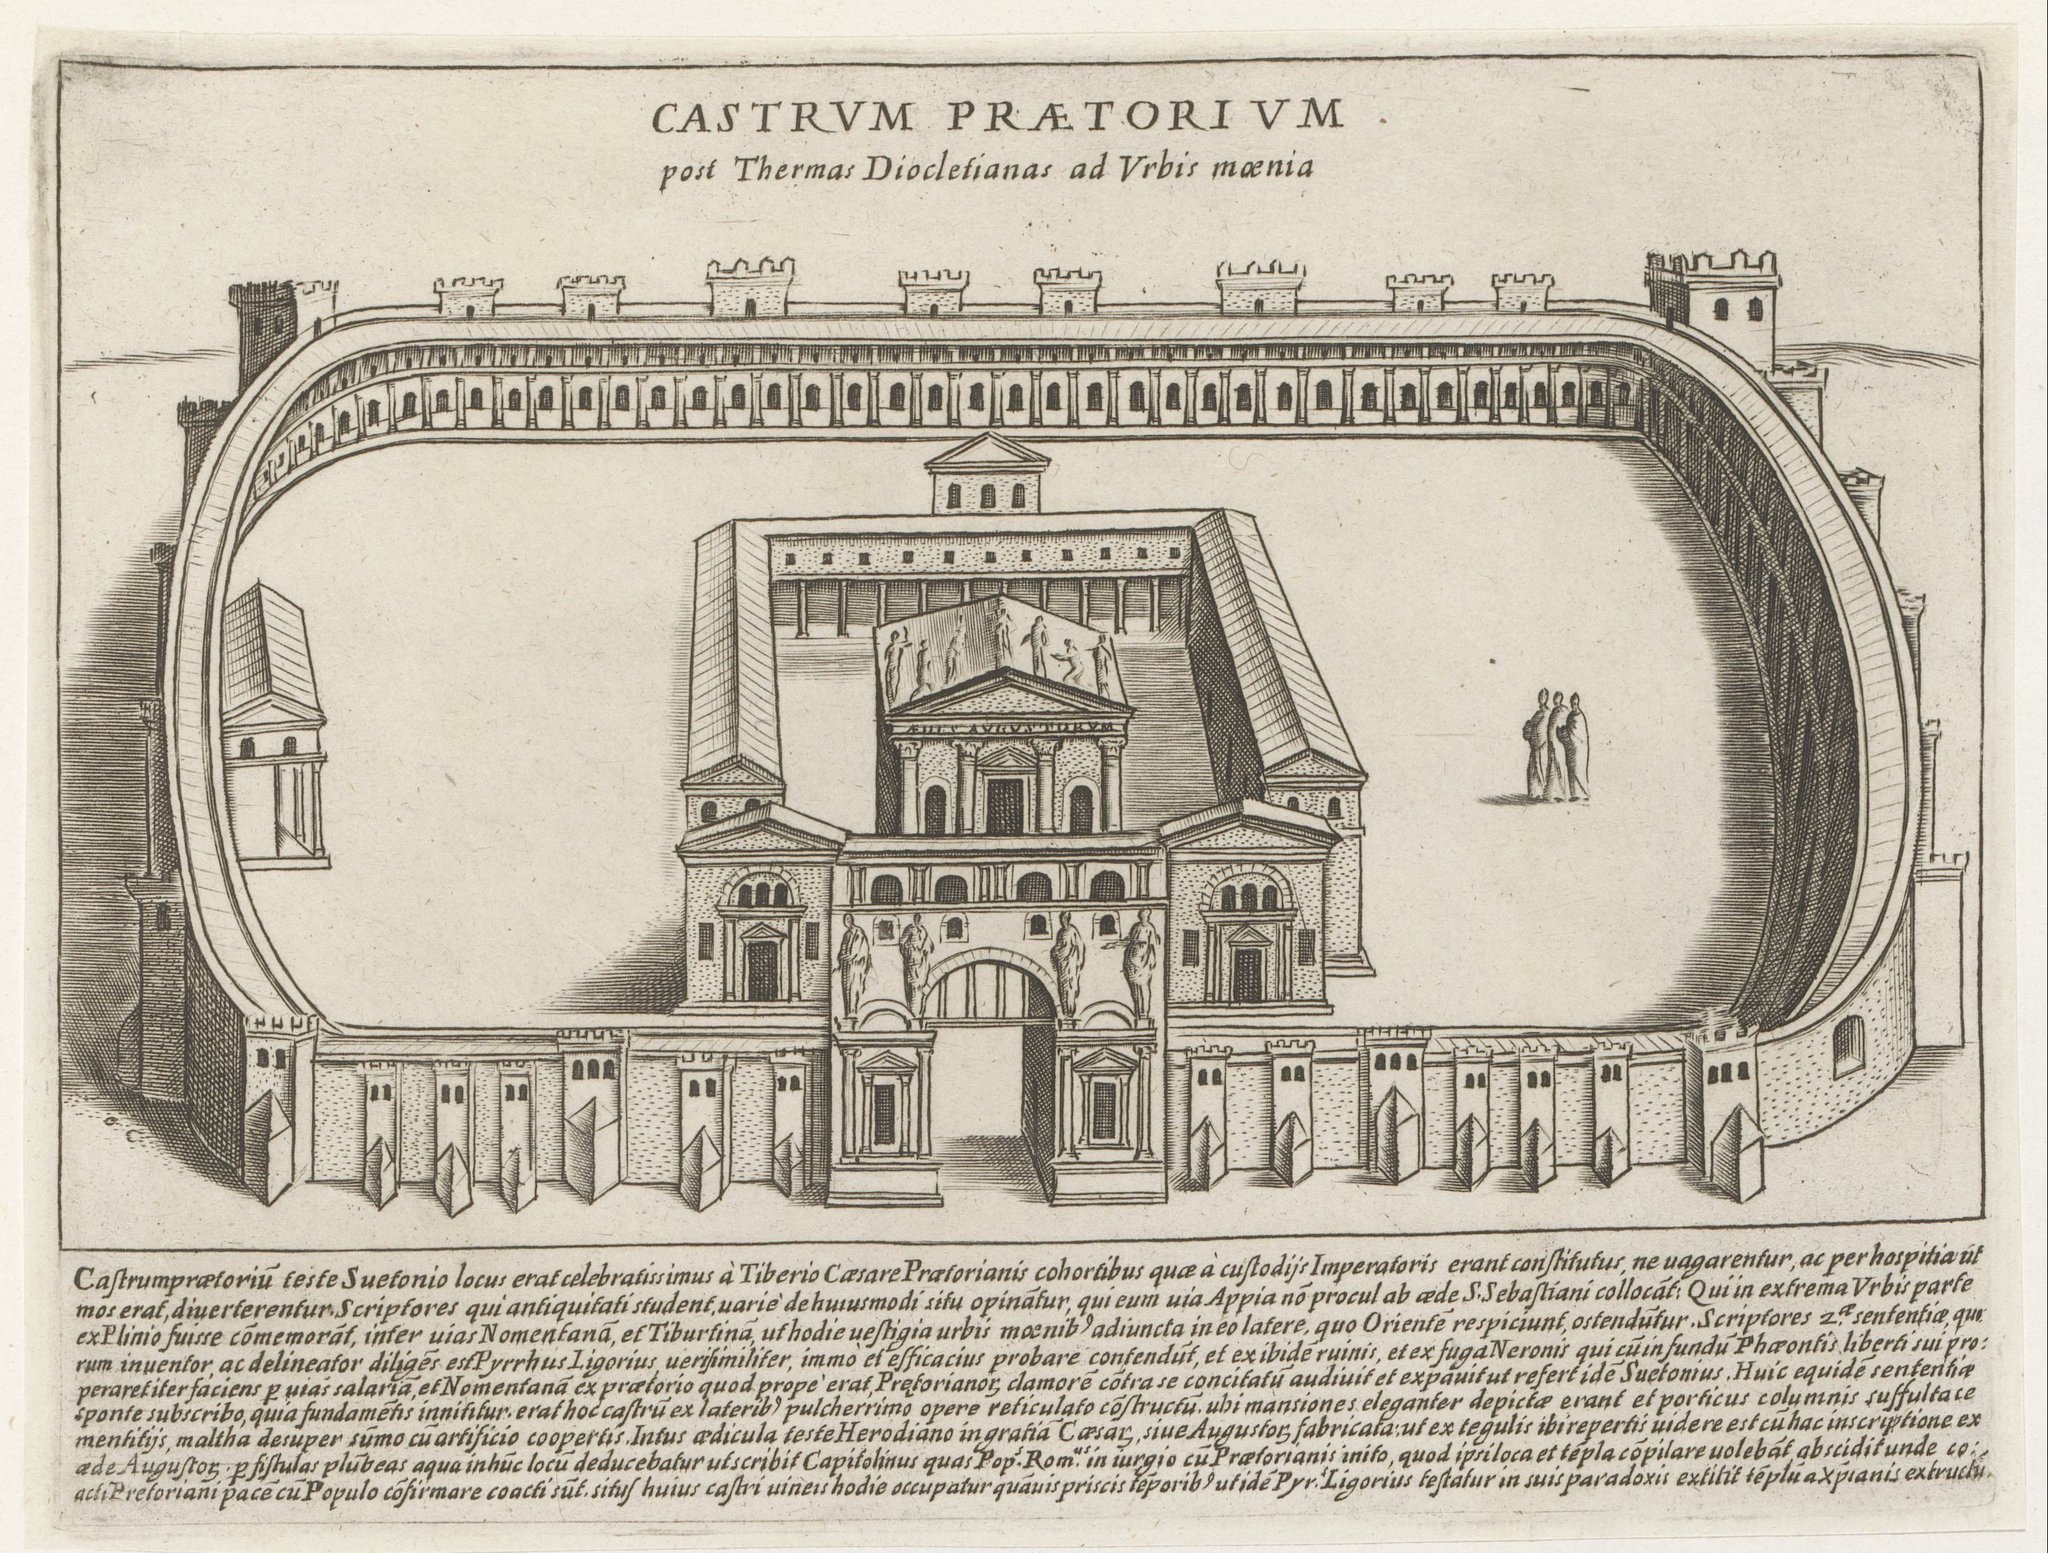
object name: print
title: Antiquae Urbis Splendor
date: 1612-1628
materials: paper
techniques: etching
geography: rome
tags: representation of real building (either existing or having existed), barracks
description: Deze prent maakt deel uit van een set van 158 prenten (+ titelprenten), die verscheen in vier delen. In 1612 verschenen delen één en twee. In 1615 verscheen het derde deel en in 1628 verscheen deel vier. In 1637 publiceerde Vitale Mascardi de eerste heruitgave van de gehele set met nummering.